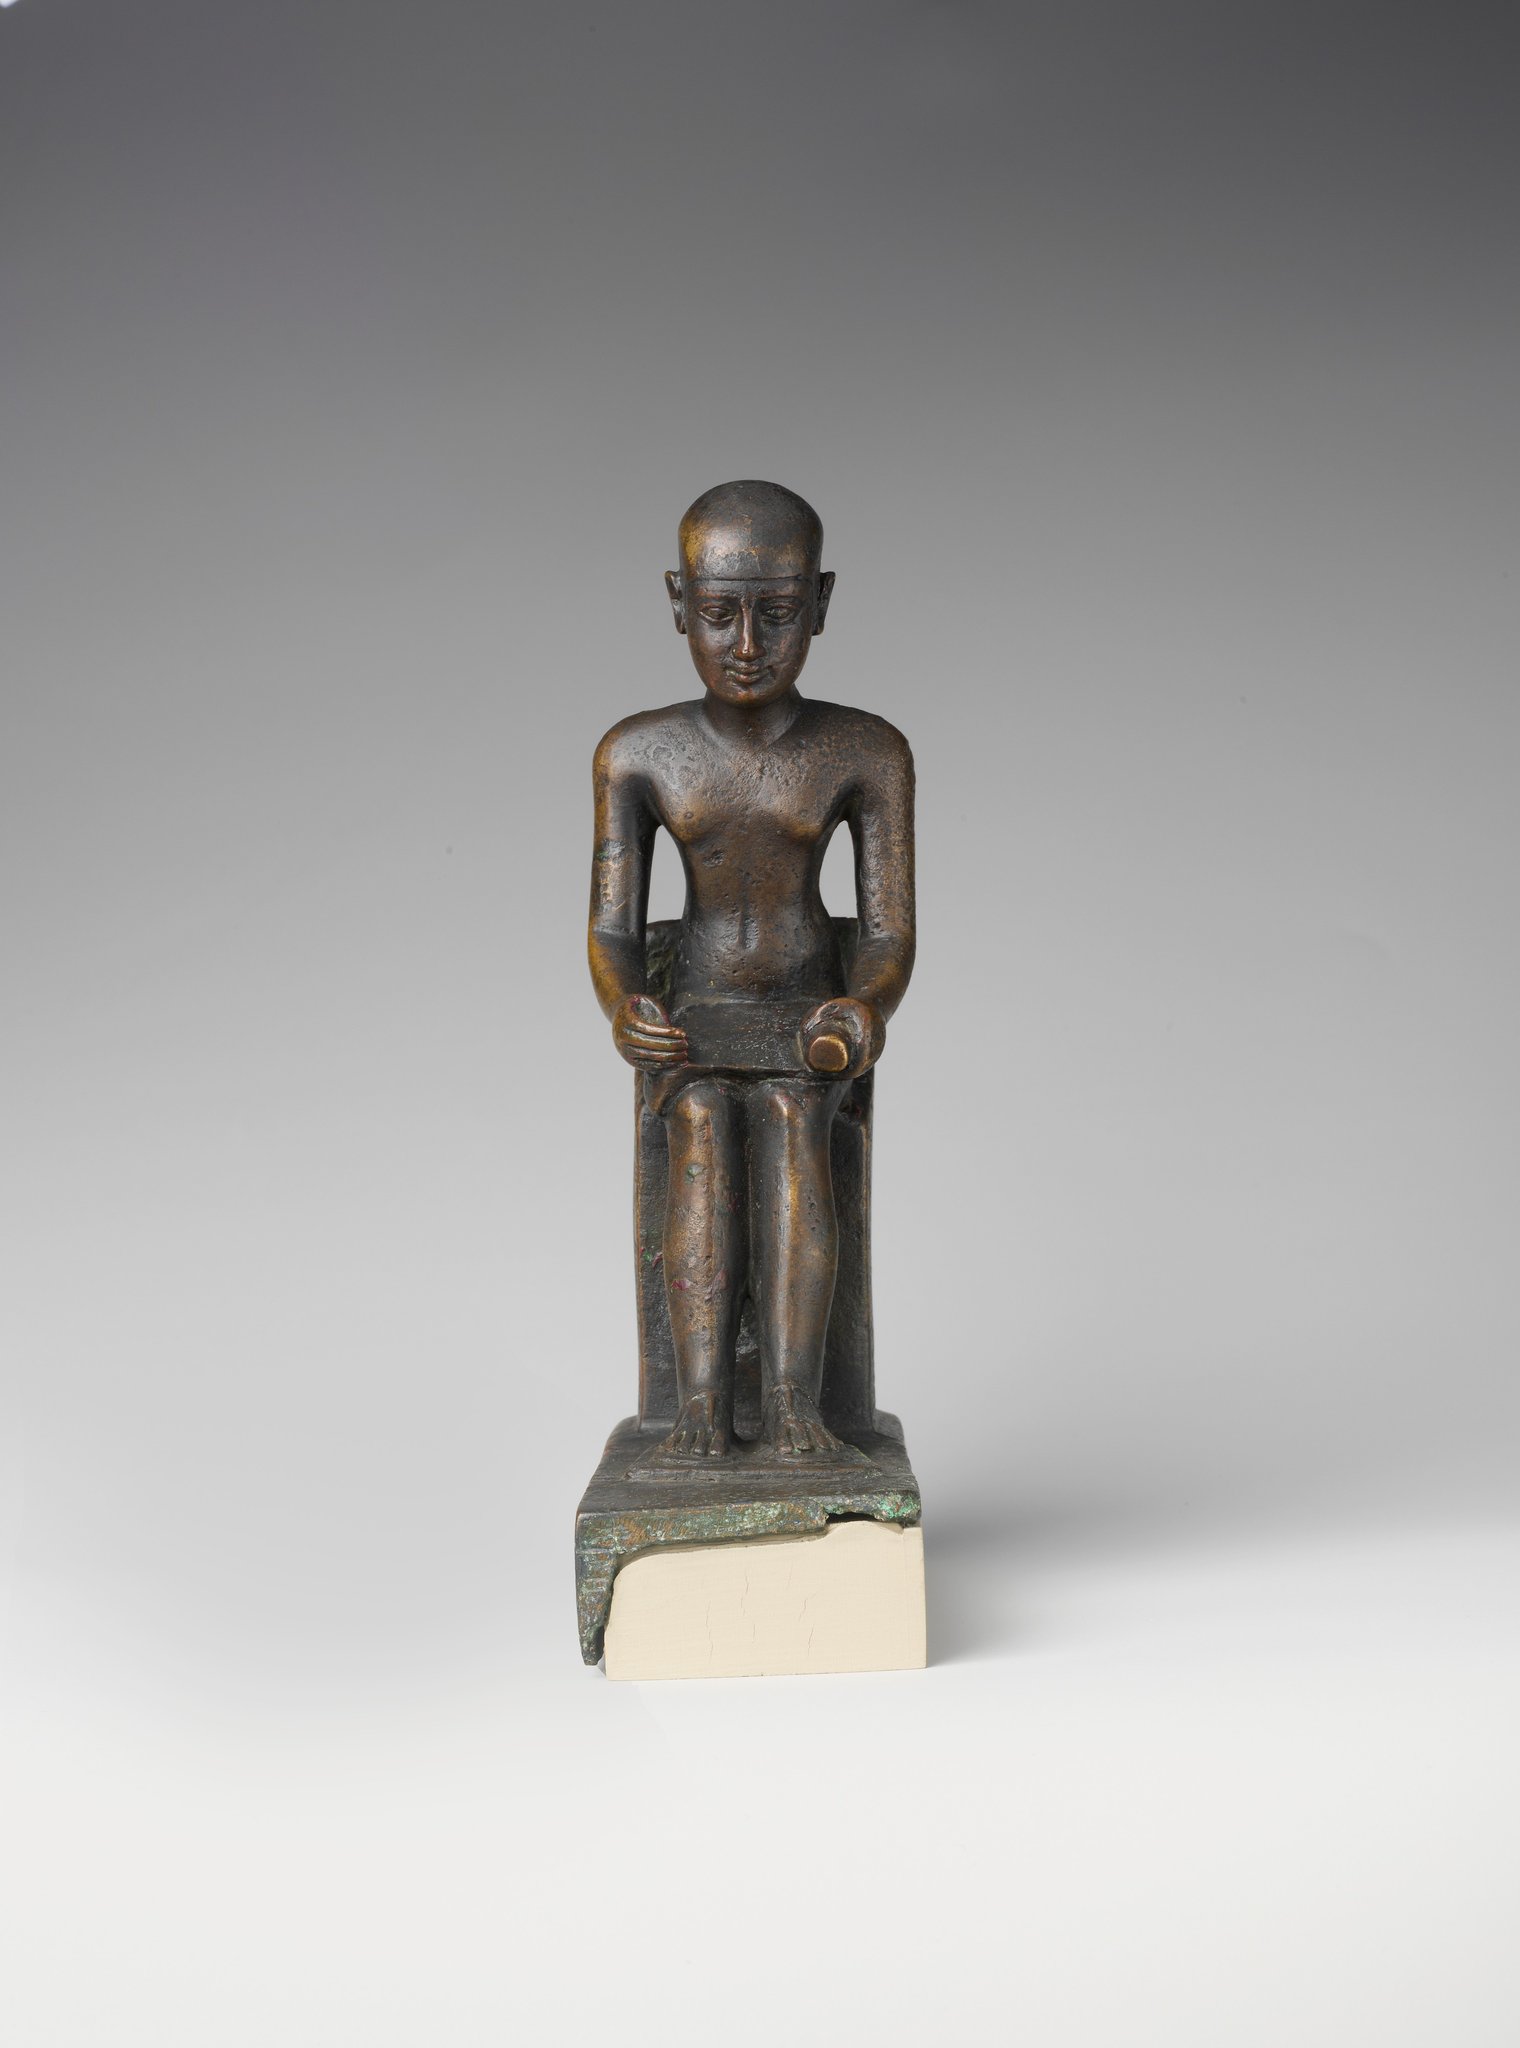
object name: statuette, imhotep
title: Imhotep, donated by Padisu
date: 664-630 BCE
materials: metal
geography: memphite region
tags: men,hieroglyphs